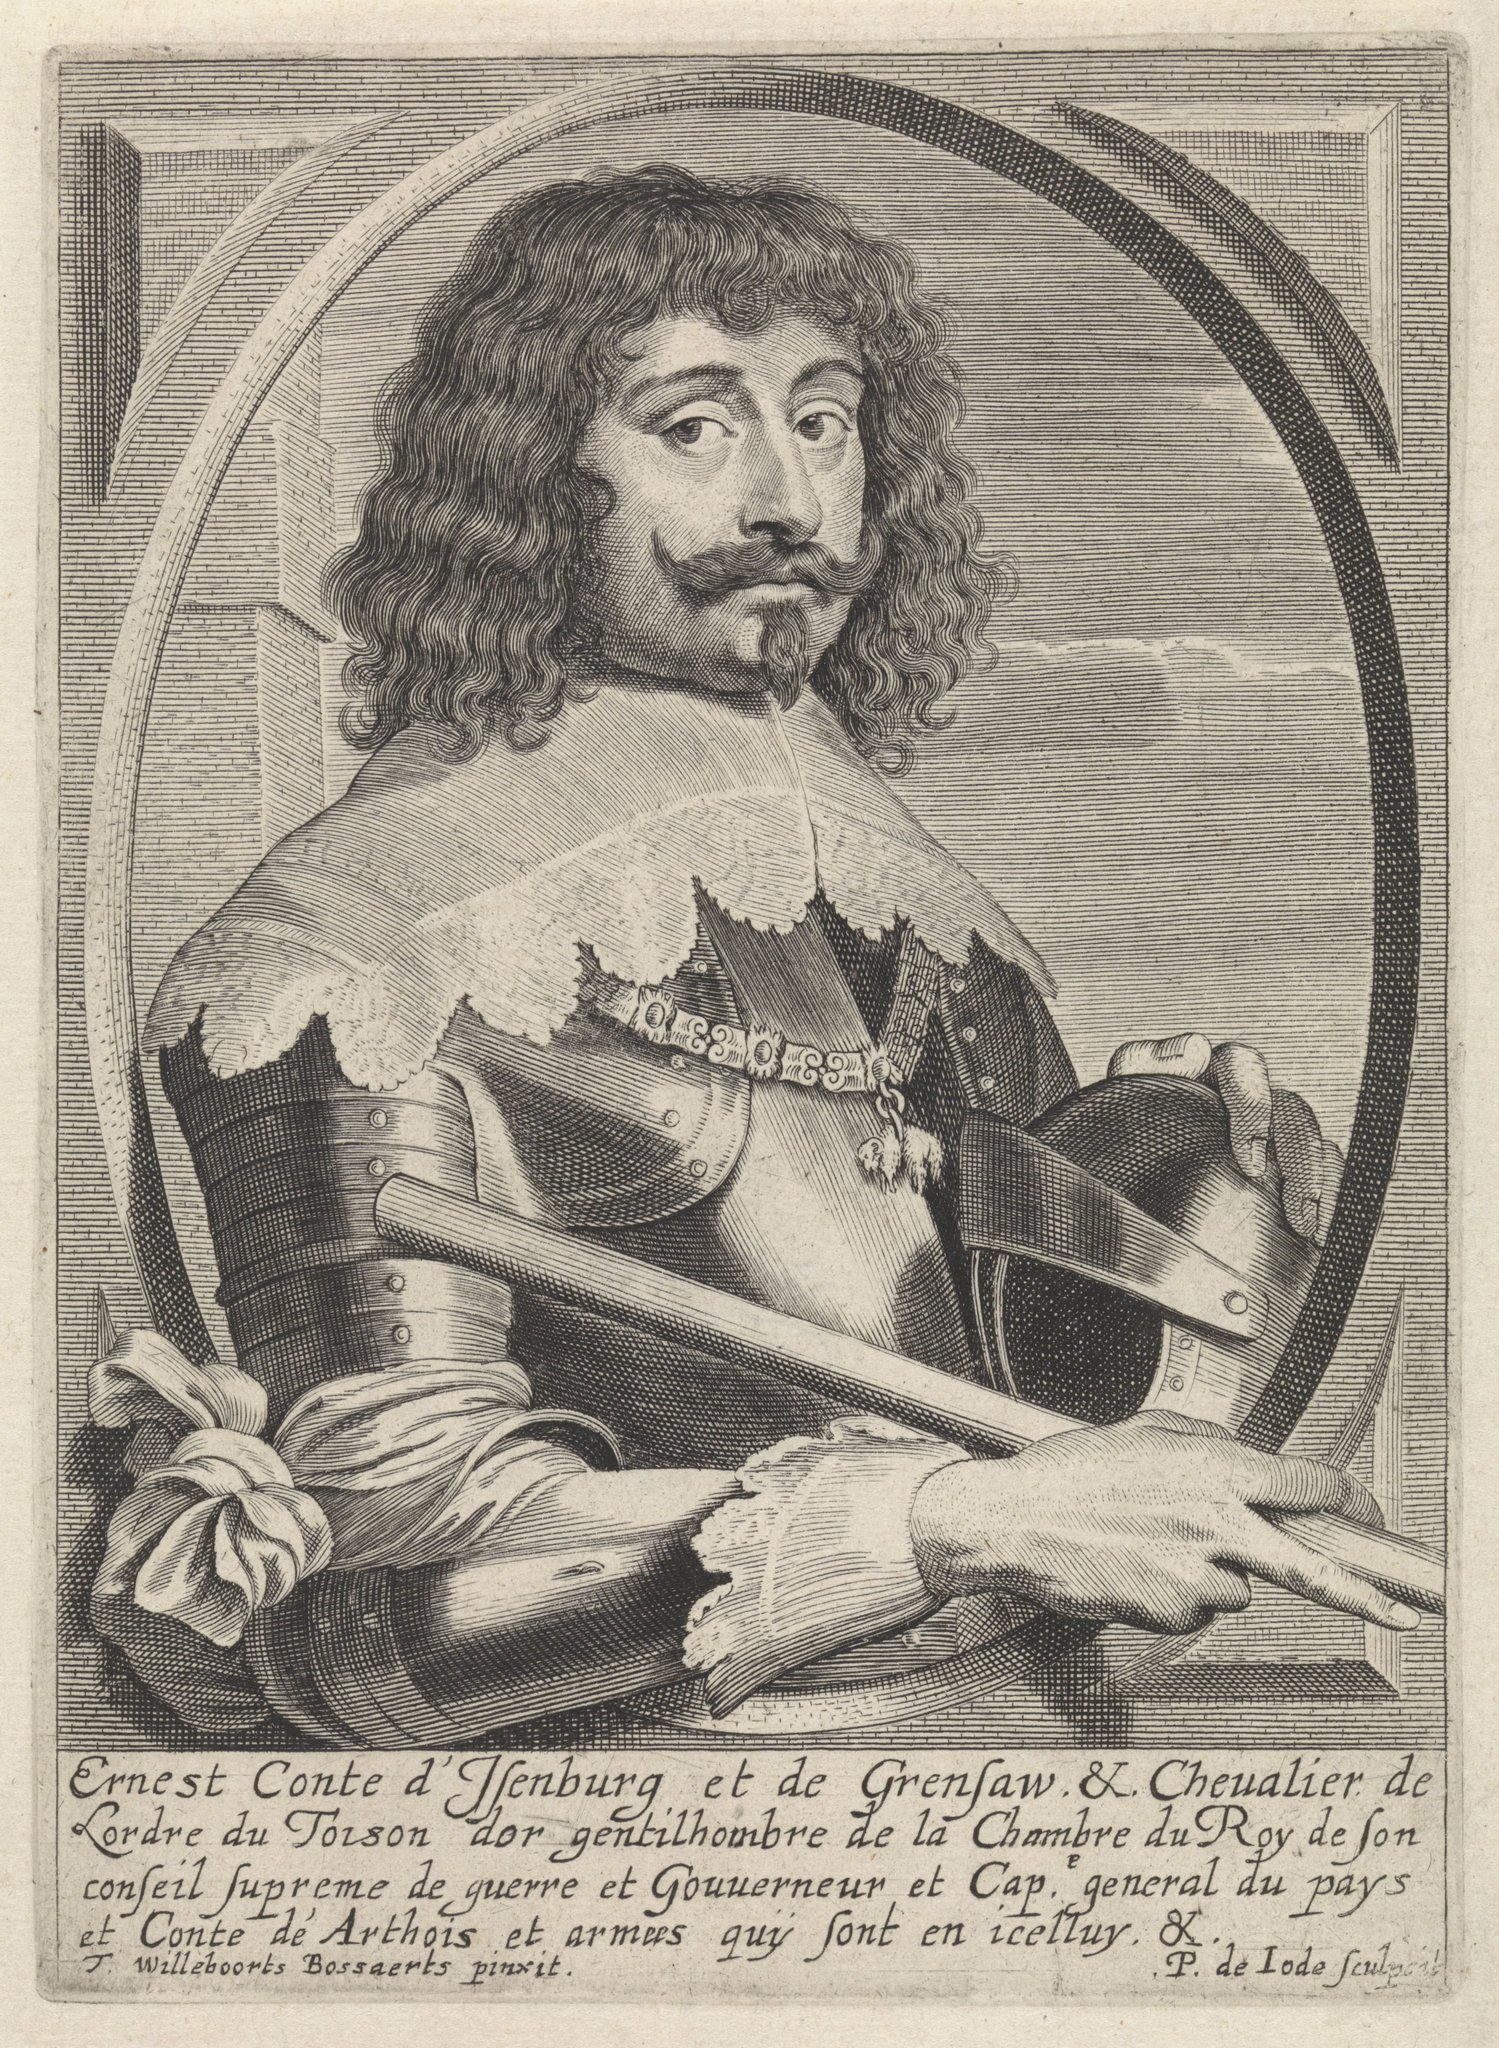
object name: print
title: Theatrum pontificum, imperatorum, regum, ducum, principum, etc.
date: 1628-1670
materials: paper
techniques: engraving, etching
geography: antwerp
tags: armour, knighthood order of the golden fleece, baton of general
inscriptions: collector's mark: Lugt 2228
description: Busteportret van Ernst, graaf van Isenburg, in harnas. Met zijn linkerhand rust hij op een helm en met zijn rechterarm rust hij op de omlijsting. In zijn rechterhand houdt hij een commandostaf. Hij draagt een een keten met de Orde van het Gulden Vlies. Het portret is gevat in een ovale omlijsting met vierkant randwerk. In de marge een vierregelig onderschrift in het Frans.